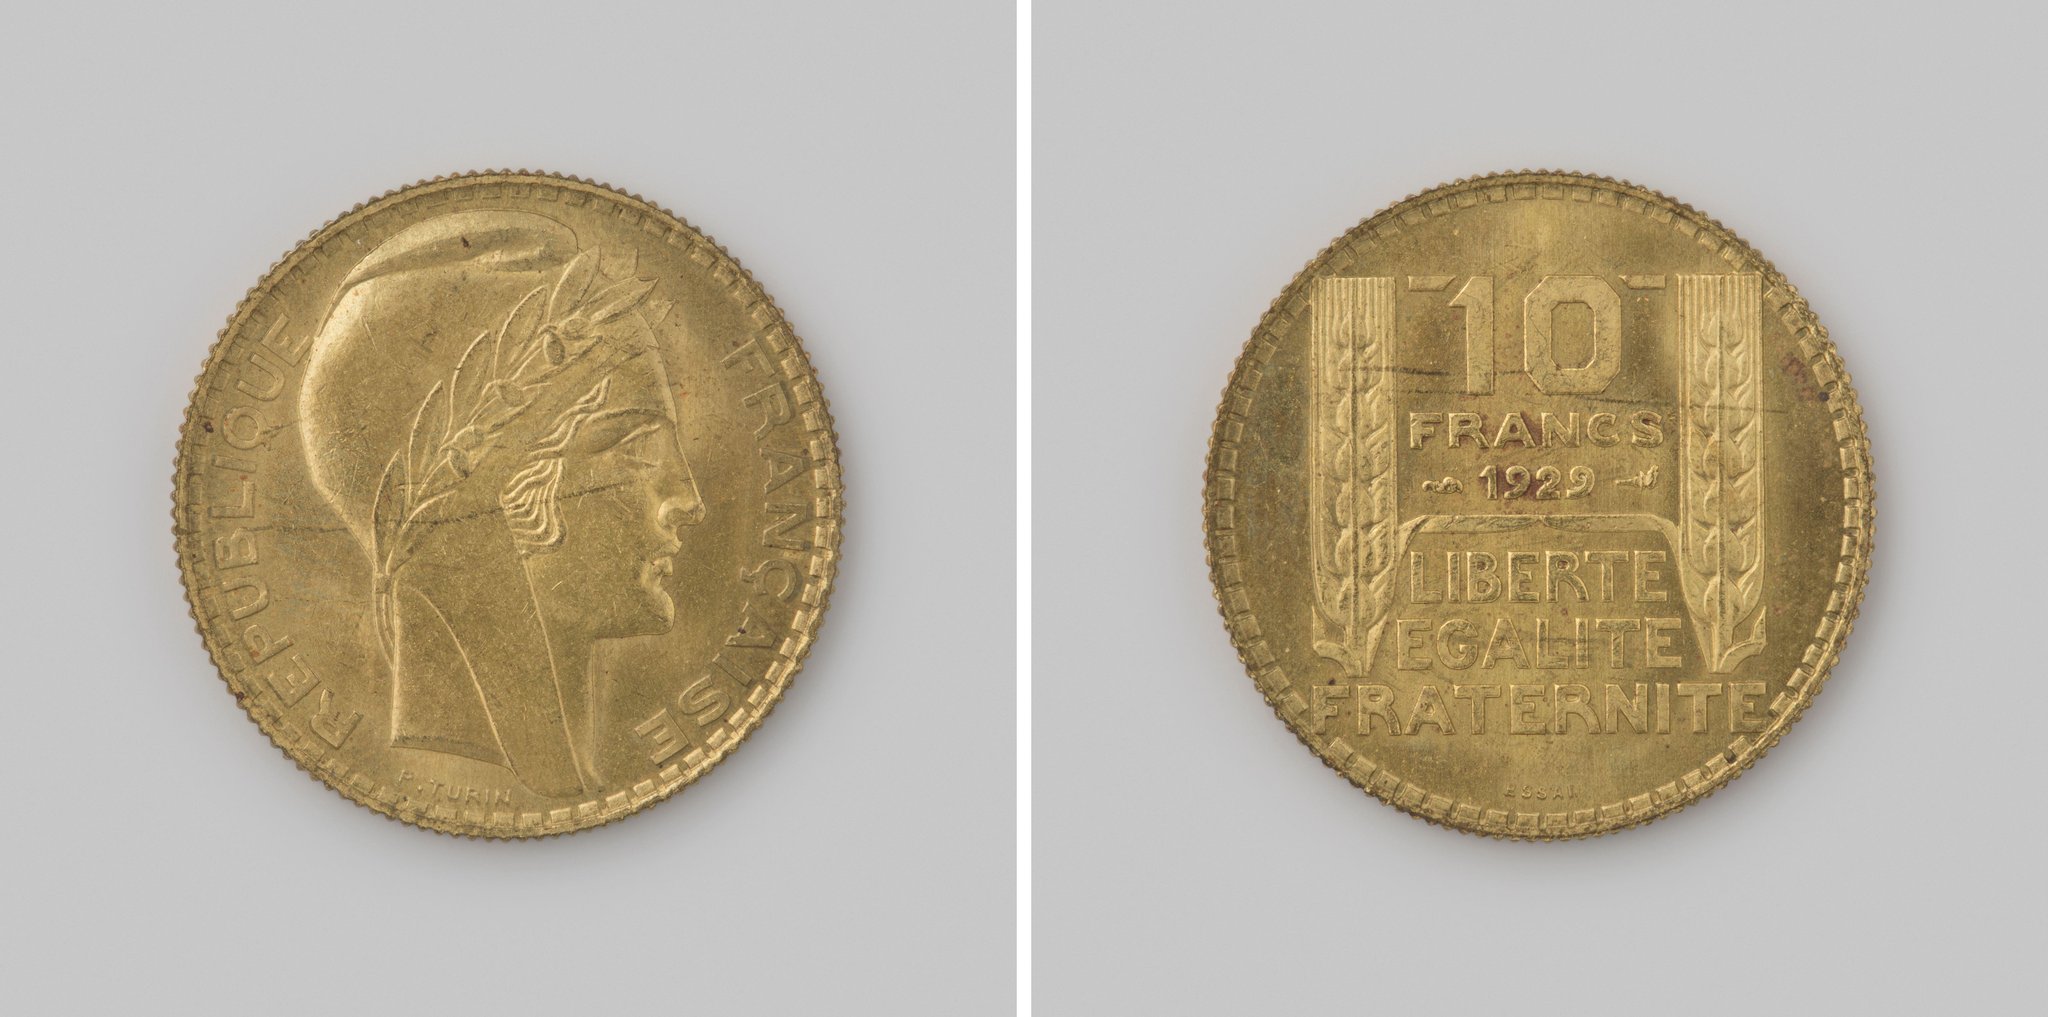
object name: tien franc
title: Frankrijk, Derde Republiek, 10 francs,1929, essai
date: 1929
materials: bronze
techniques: striking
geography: paris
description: Proef in aluminium-brons van de ontwerper P.Turin. Voorzijde: hoofd van een vrouw met lauwerkrans en vrijheidshoed op het haar naar rechts. Keerzijde: tussen twee korenaren waarde-aanduiding in twee regels, waaronder jaartal. Kartelrand.